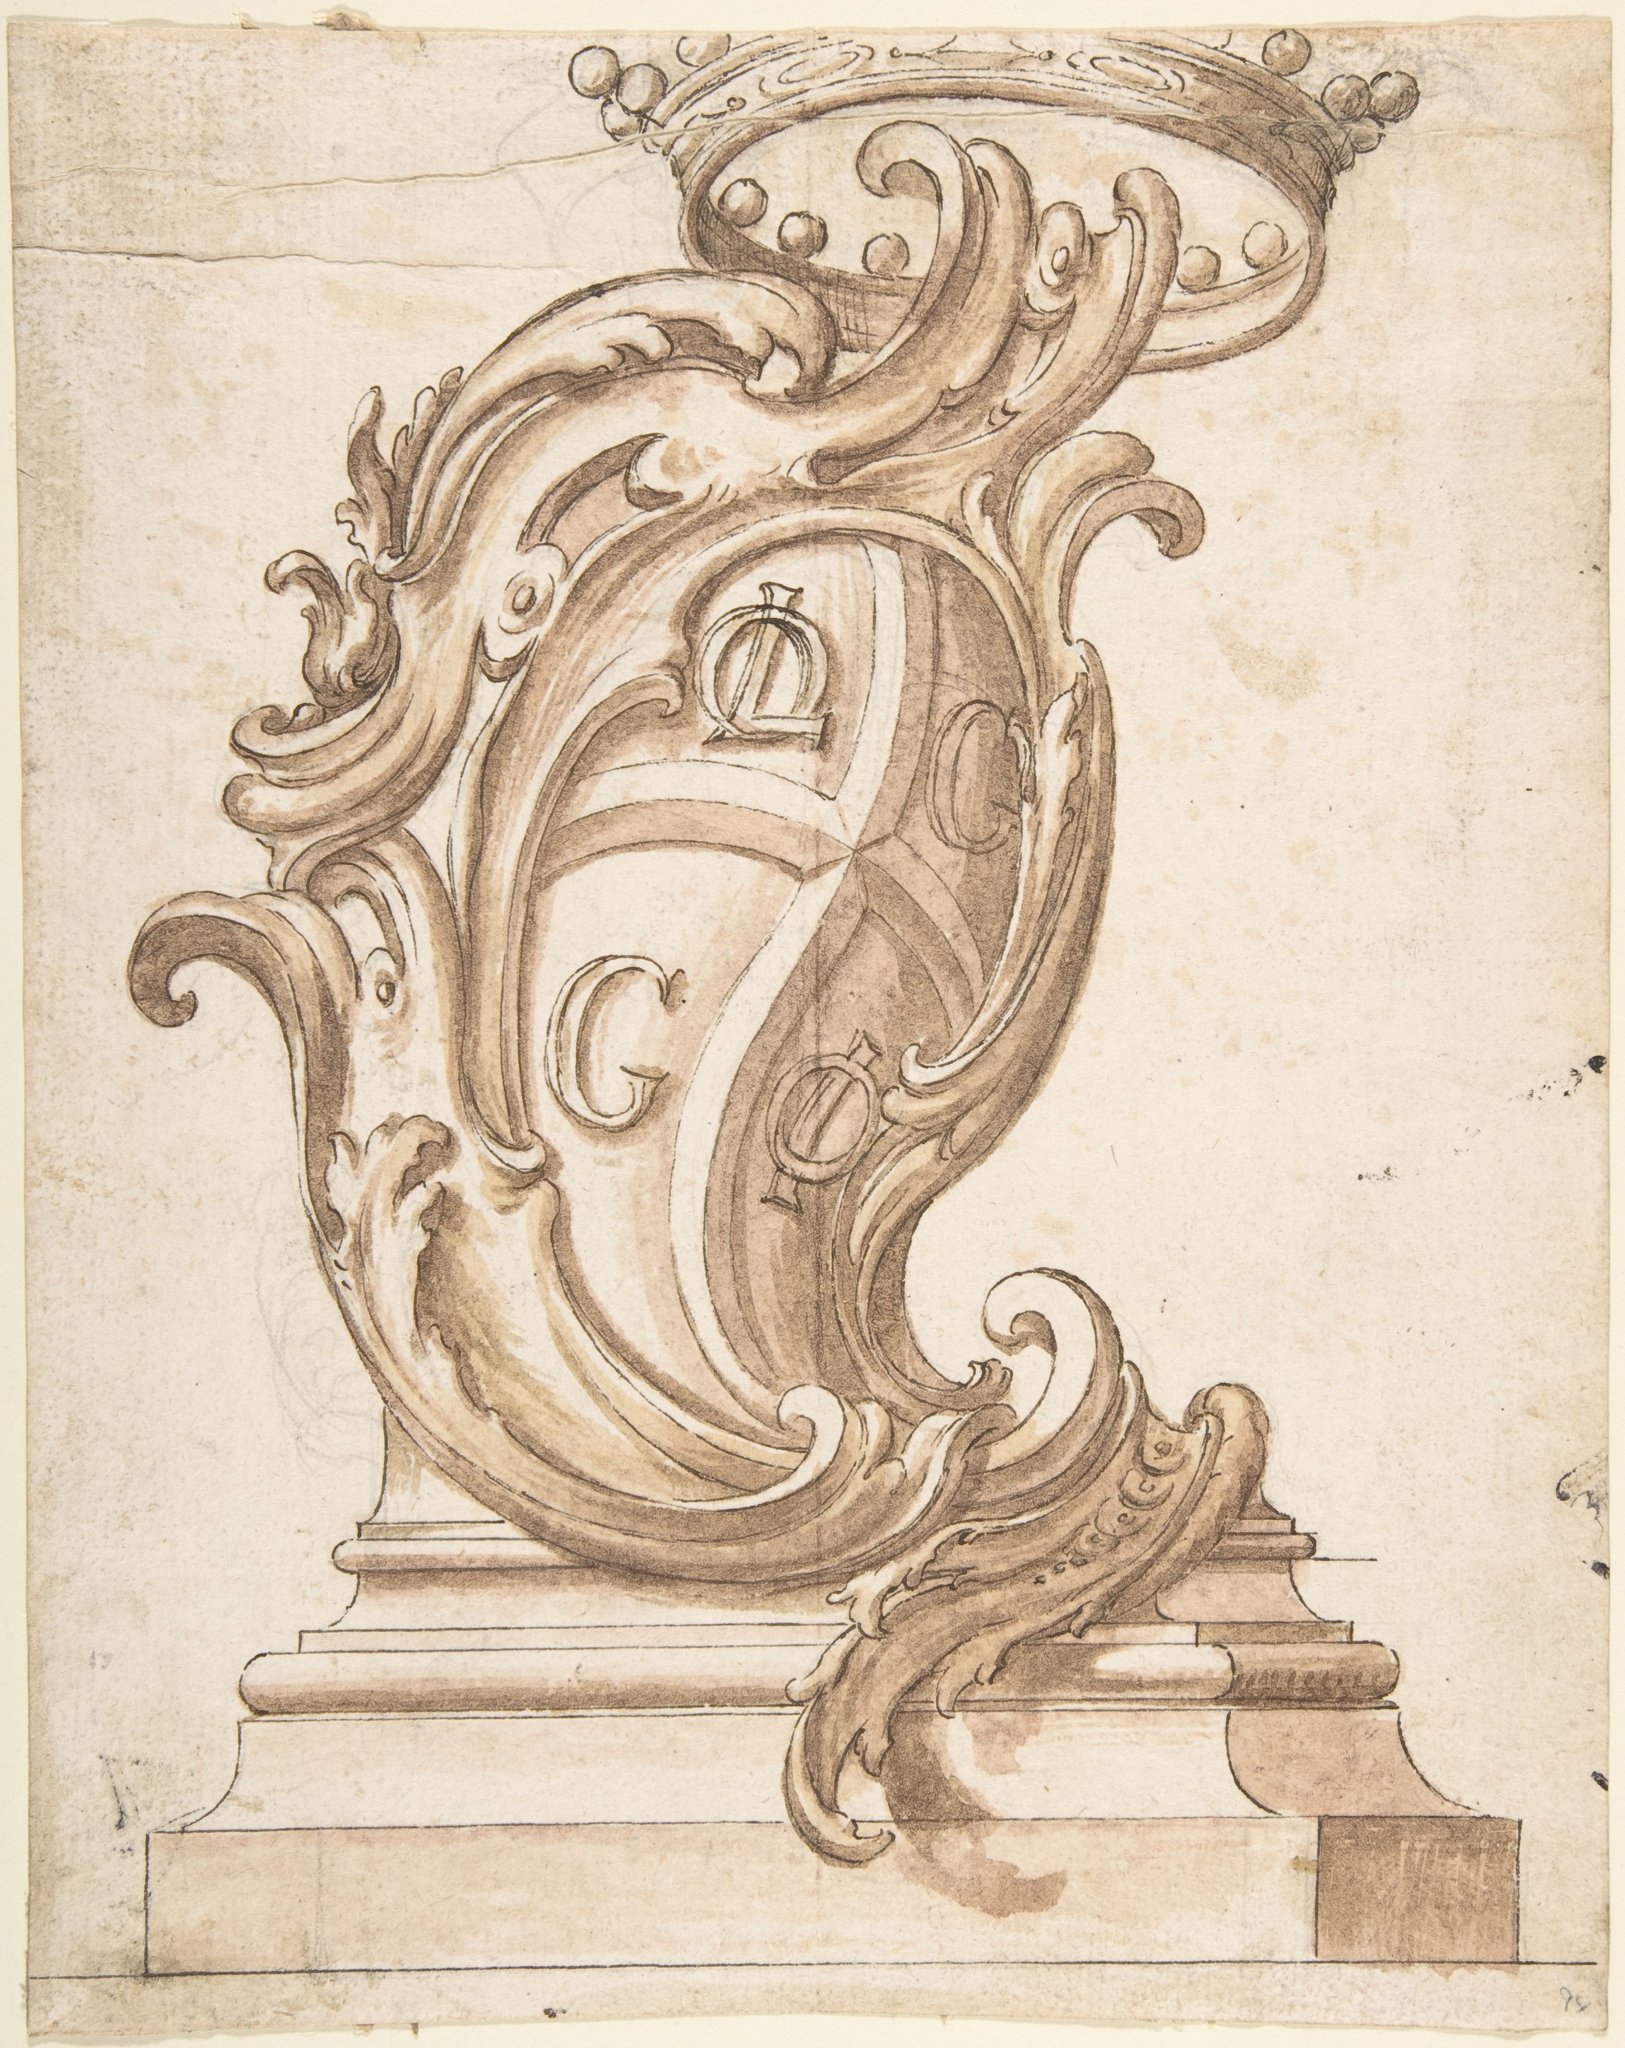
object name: drawing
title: Design for a Cartouche on a Base, Surmounted by a Crown, with Arms with the Initials OL, G, G, and OI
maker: anonymous, italian, piedmontese, 18th century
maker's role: artist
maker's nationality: italian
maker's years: 1700-1800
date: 1700-1780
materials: graphite, ink, drawing material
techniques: brush, pen, wash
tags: diadems,cartouches,coat of arms